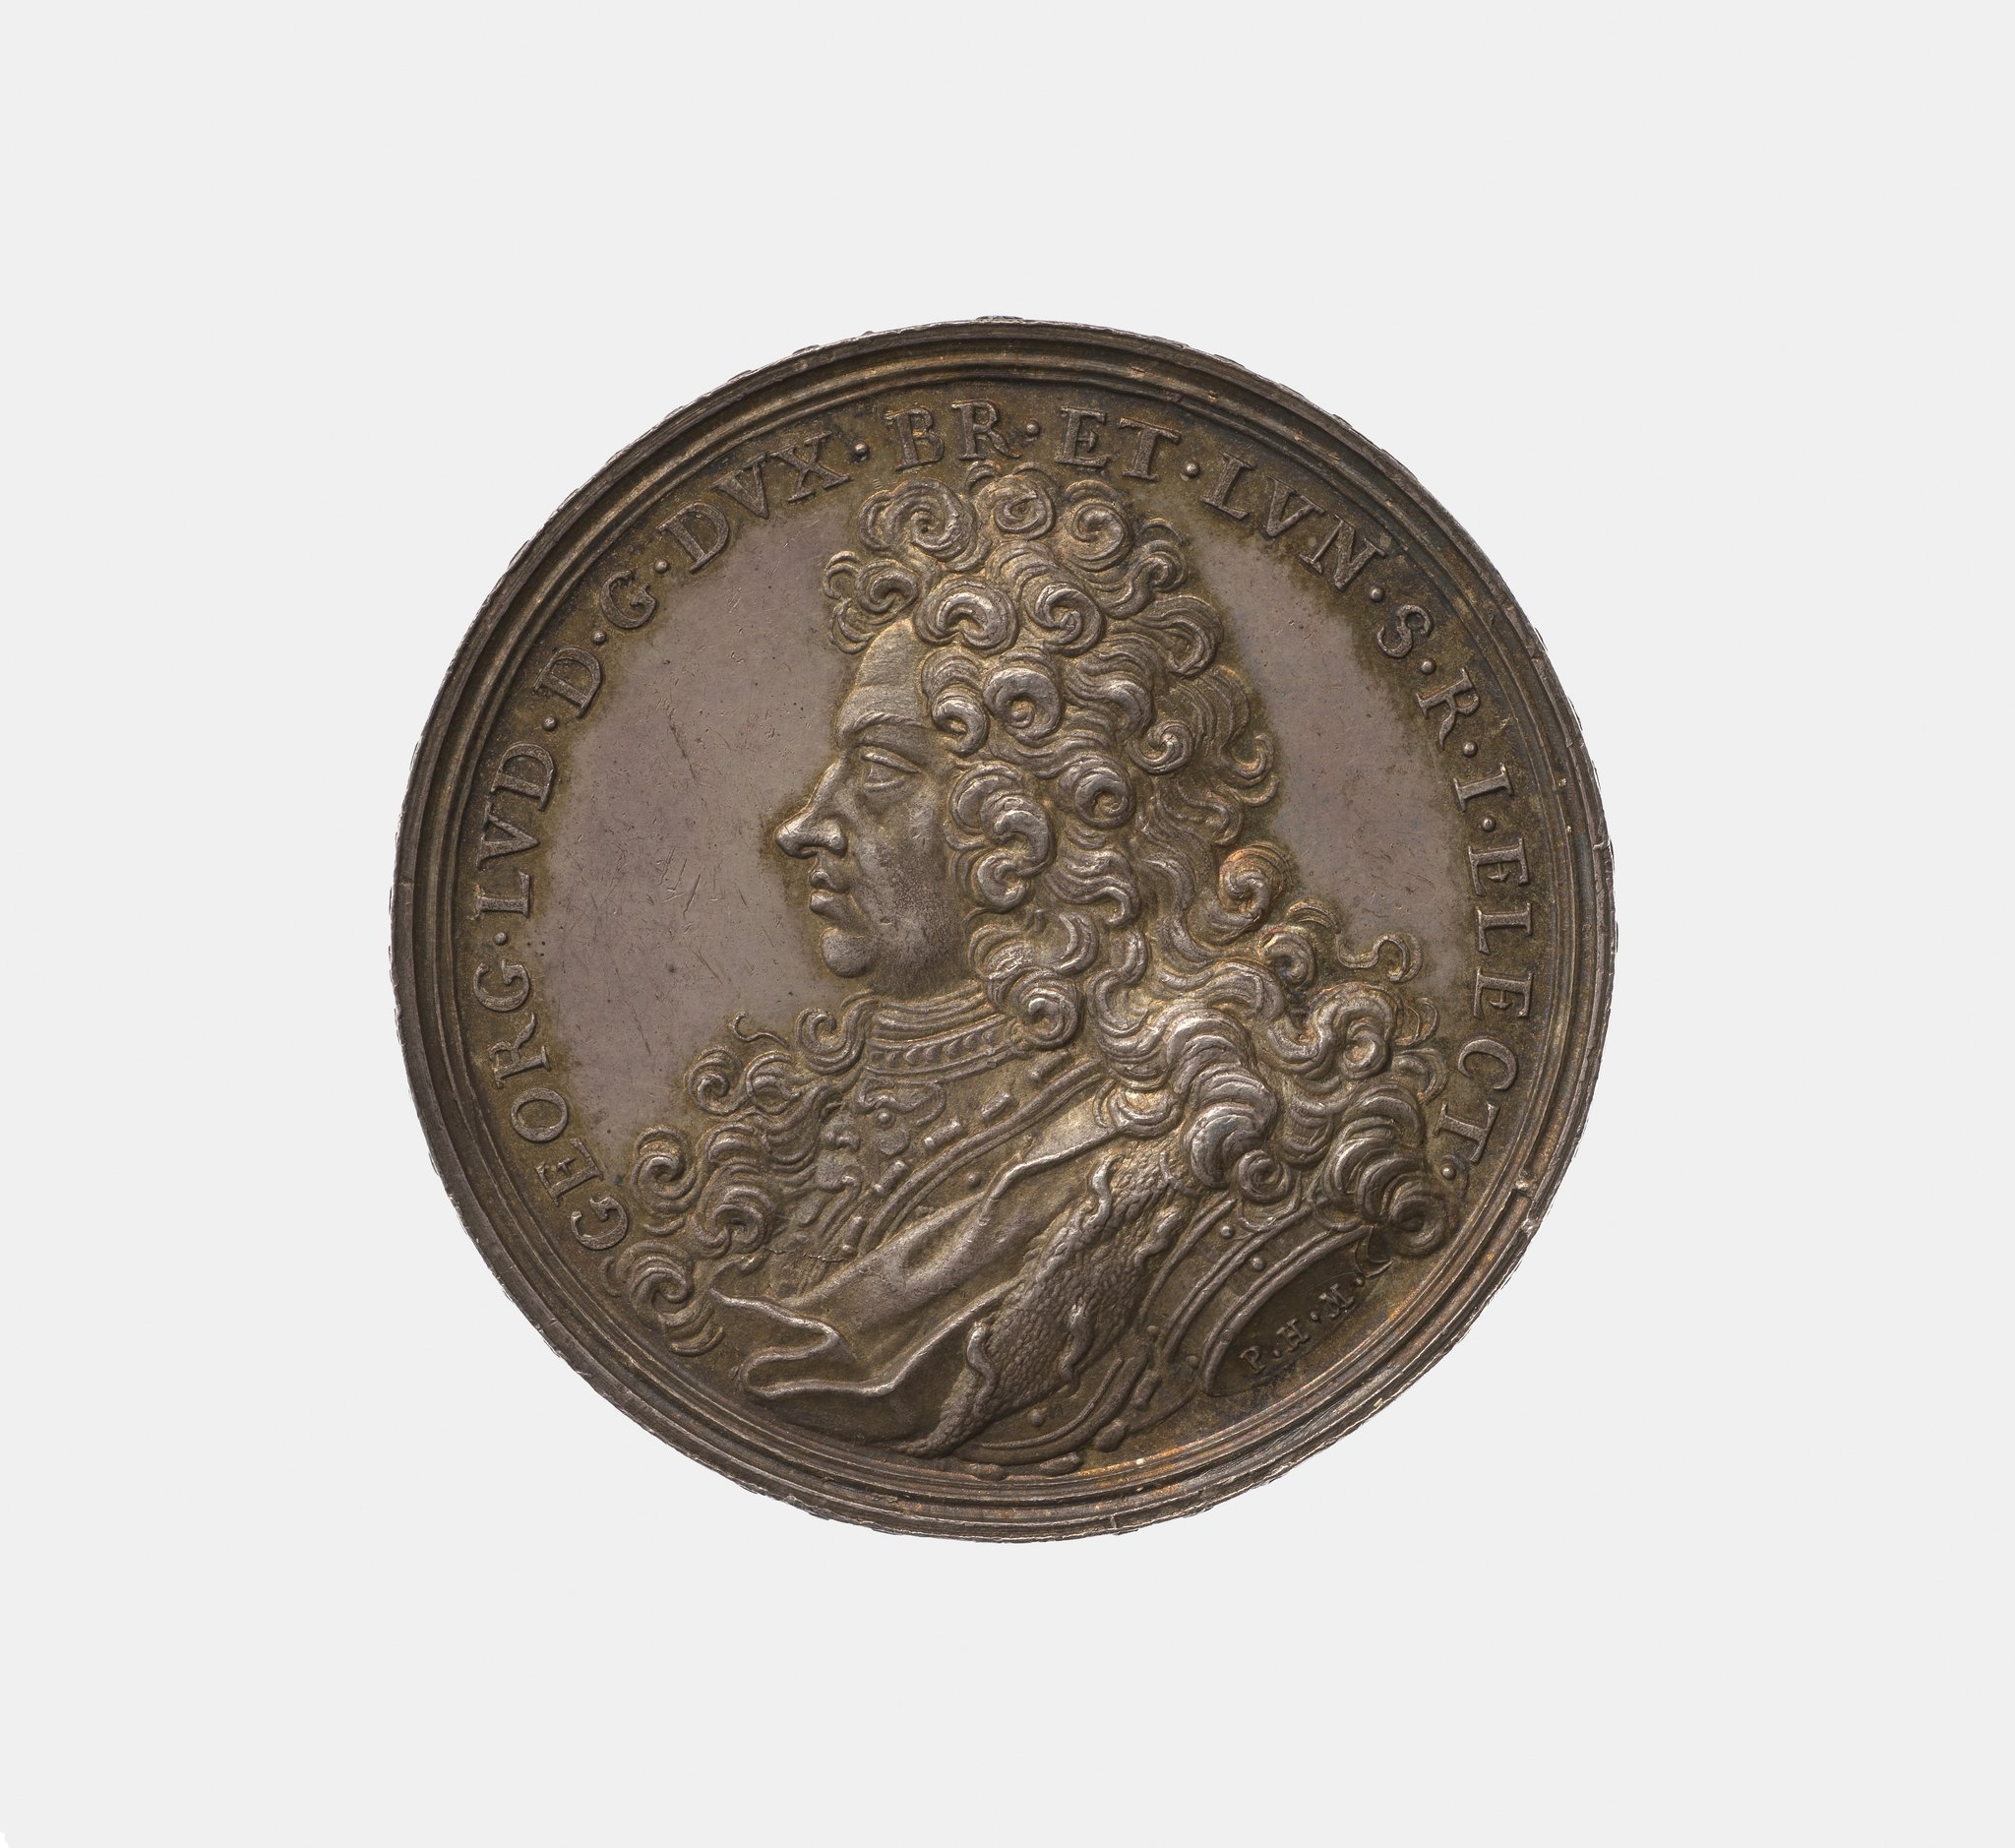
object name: medal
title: Appointment of Georg Ludwig (Geroge I) as general of the imperial troops on the Rhine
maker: philipp heinrich müller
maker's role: artist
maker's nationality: german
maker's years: 1654-1719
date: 1707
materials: silver